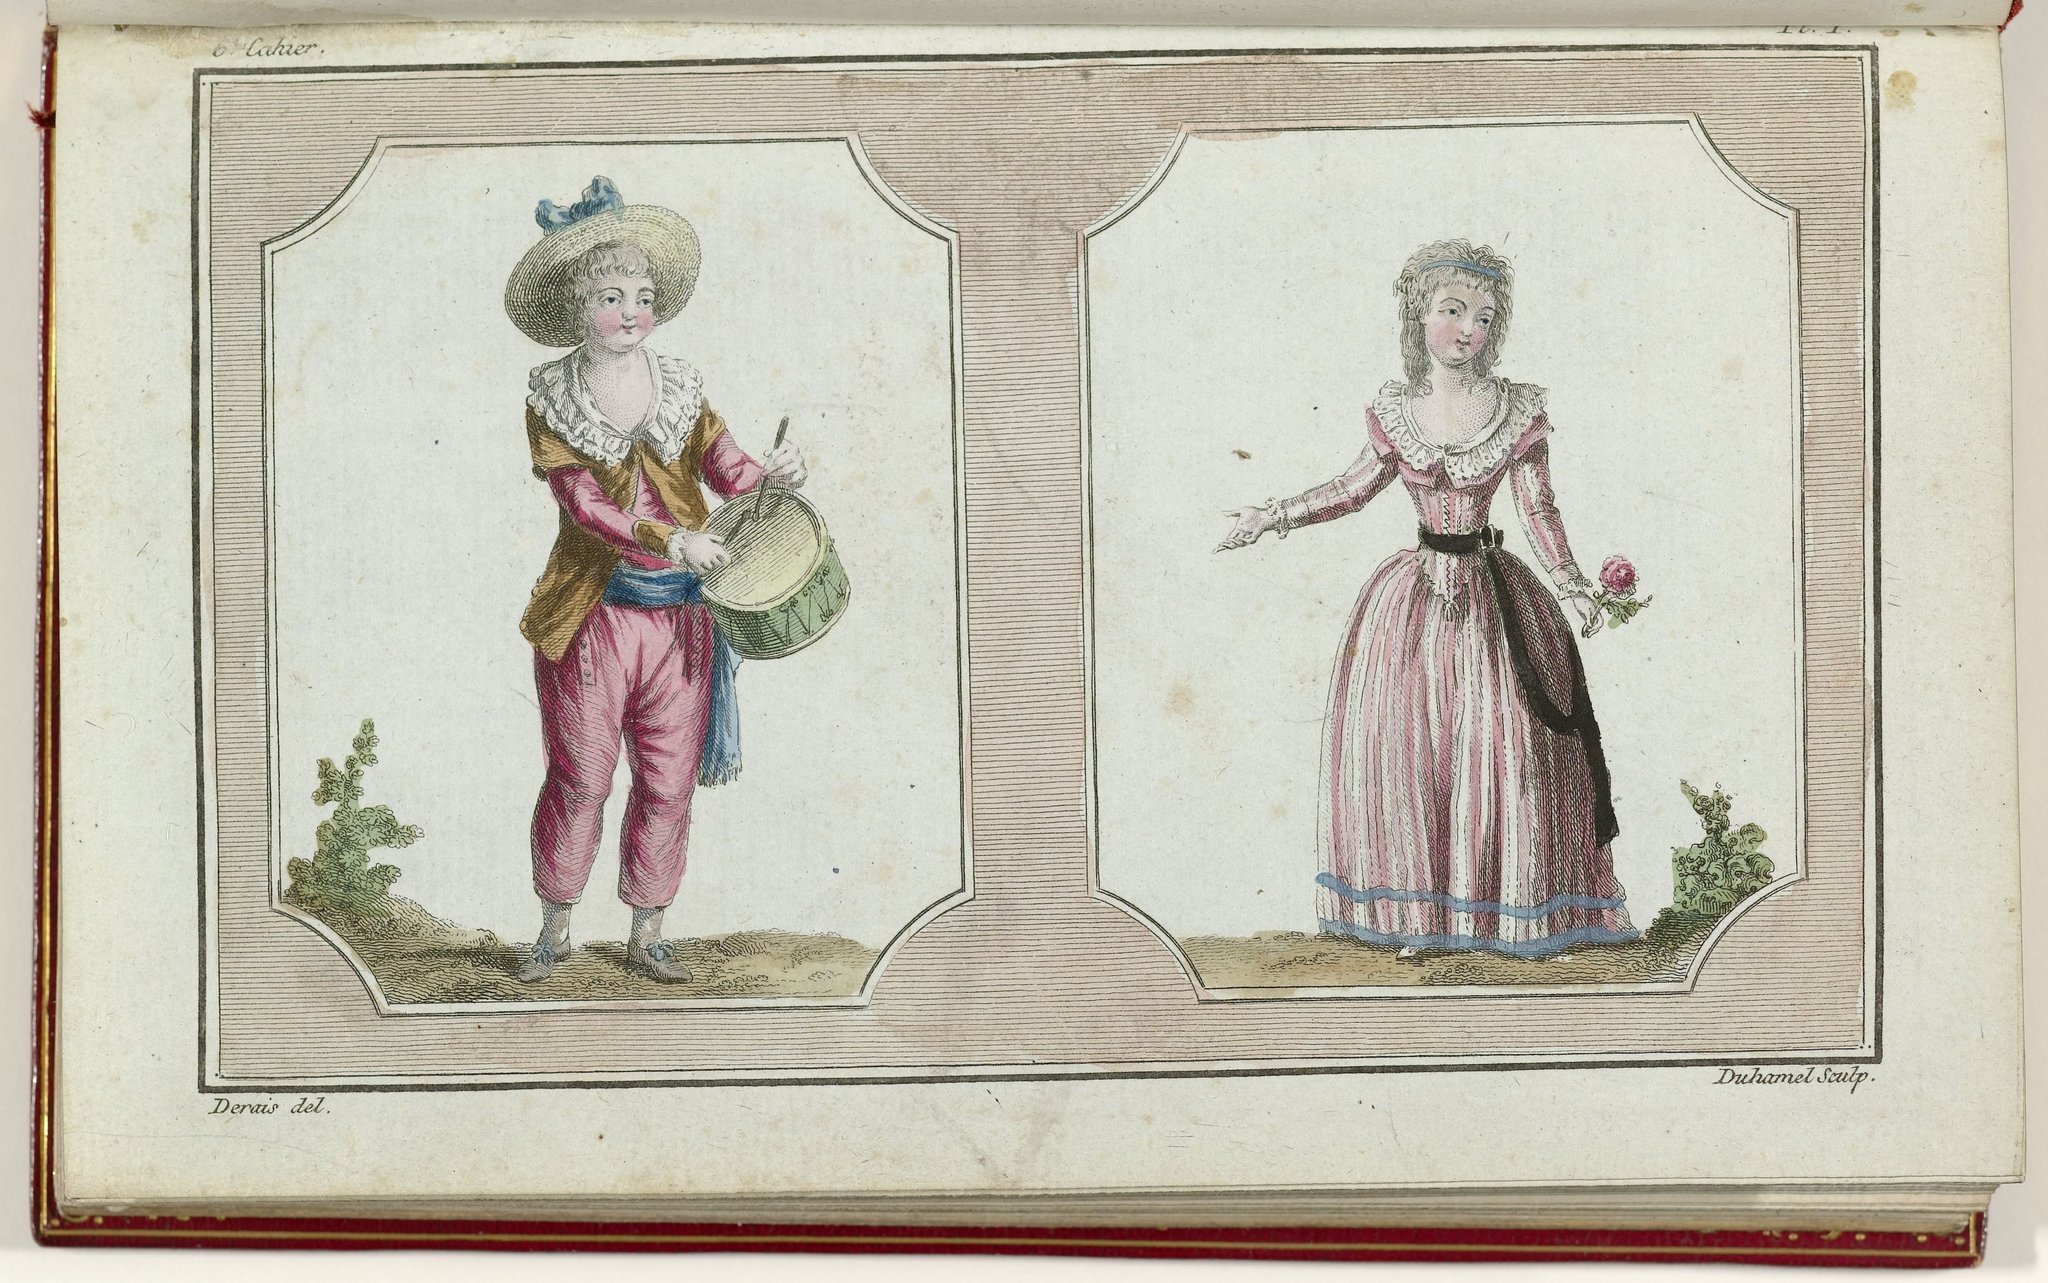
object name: fashion print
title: Cabinet des Modes ou les Modes Nouvelles, 1 Février 1786, 6e cahier, pl. I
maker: buisson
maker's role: publisher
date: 1786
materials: paper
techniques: engraving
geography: paris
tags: skirt (+ girls' clothes), head-gear: hat (+ girls' clothes), trousers, breeches (+ boys' clothes), clothing for the upper part of the body (vest) (+ boys' clothes), shoes, sandals (+ boys' clothes), head-gear: hat (+ boys' clothes), shoes, sandals (+ girls' clothes), belt, girdle, waistband (+ girls' clothes), stockings, socks (+ boys' clothes), clothing for the upper part of the body (bodice) (+ girls' clothes), fashion plates, drum (musical instrument)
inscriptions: : ‘6e cahier’, number: ‘Pl. I’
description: Twee kinderen. Links een jongen die op een trommel slaat. Volgns de begeleidende tekst draagt hij een hoed van jonc, gegarneerd met een rozet en een blauw lint. Zijn hemd heeft een colerette. Vest van satijn 'carmélite' met korte mouwen. Gilet van roze satijn, blauwe sjerp als ceintuur, broek van roze satijn '`a la marinière', witte kousen van satijn of katoen, schoenen met rozetten van blauw lint. Rechts een meisje met een roos in de hand. Half lang haar met blauw lint. Het hemd is gegarneerd met een colerette. Lijfje en rok zijn van roze tafzijde, waaronder een fourreau van witte mousseline, aan de onderrand afgezet met twee blauwe banden. Zwarte ceintuur met zilveren gesp. De prent maakt deel uit van het 6e Cahier uit de serie Cabinet des Modes ou les Modes Nouvelles. De serie bestaat uit 72 modeprenten, uitgegeven door Buisson, Parijs, 15 november 1785 - 1 november 1786.